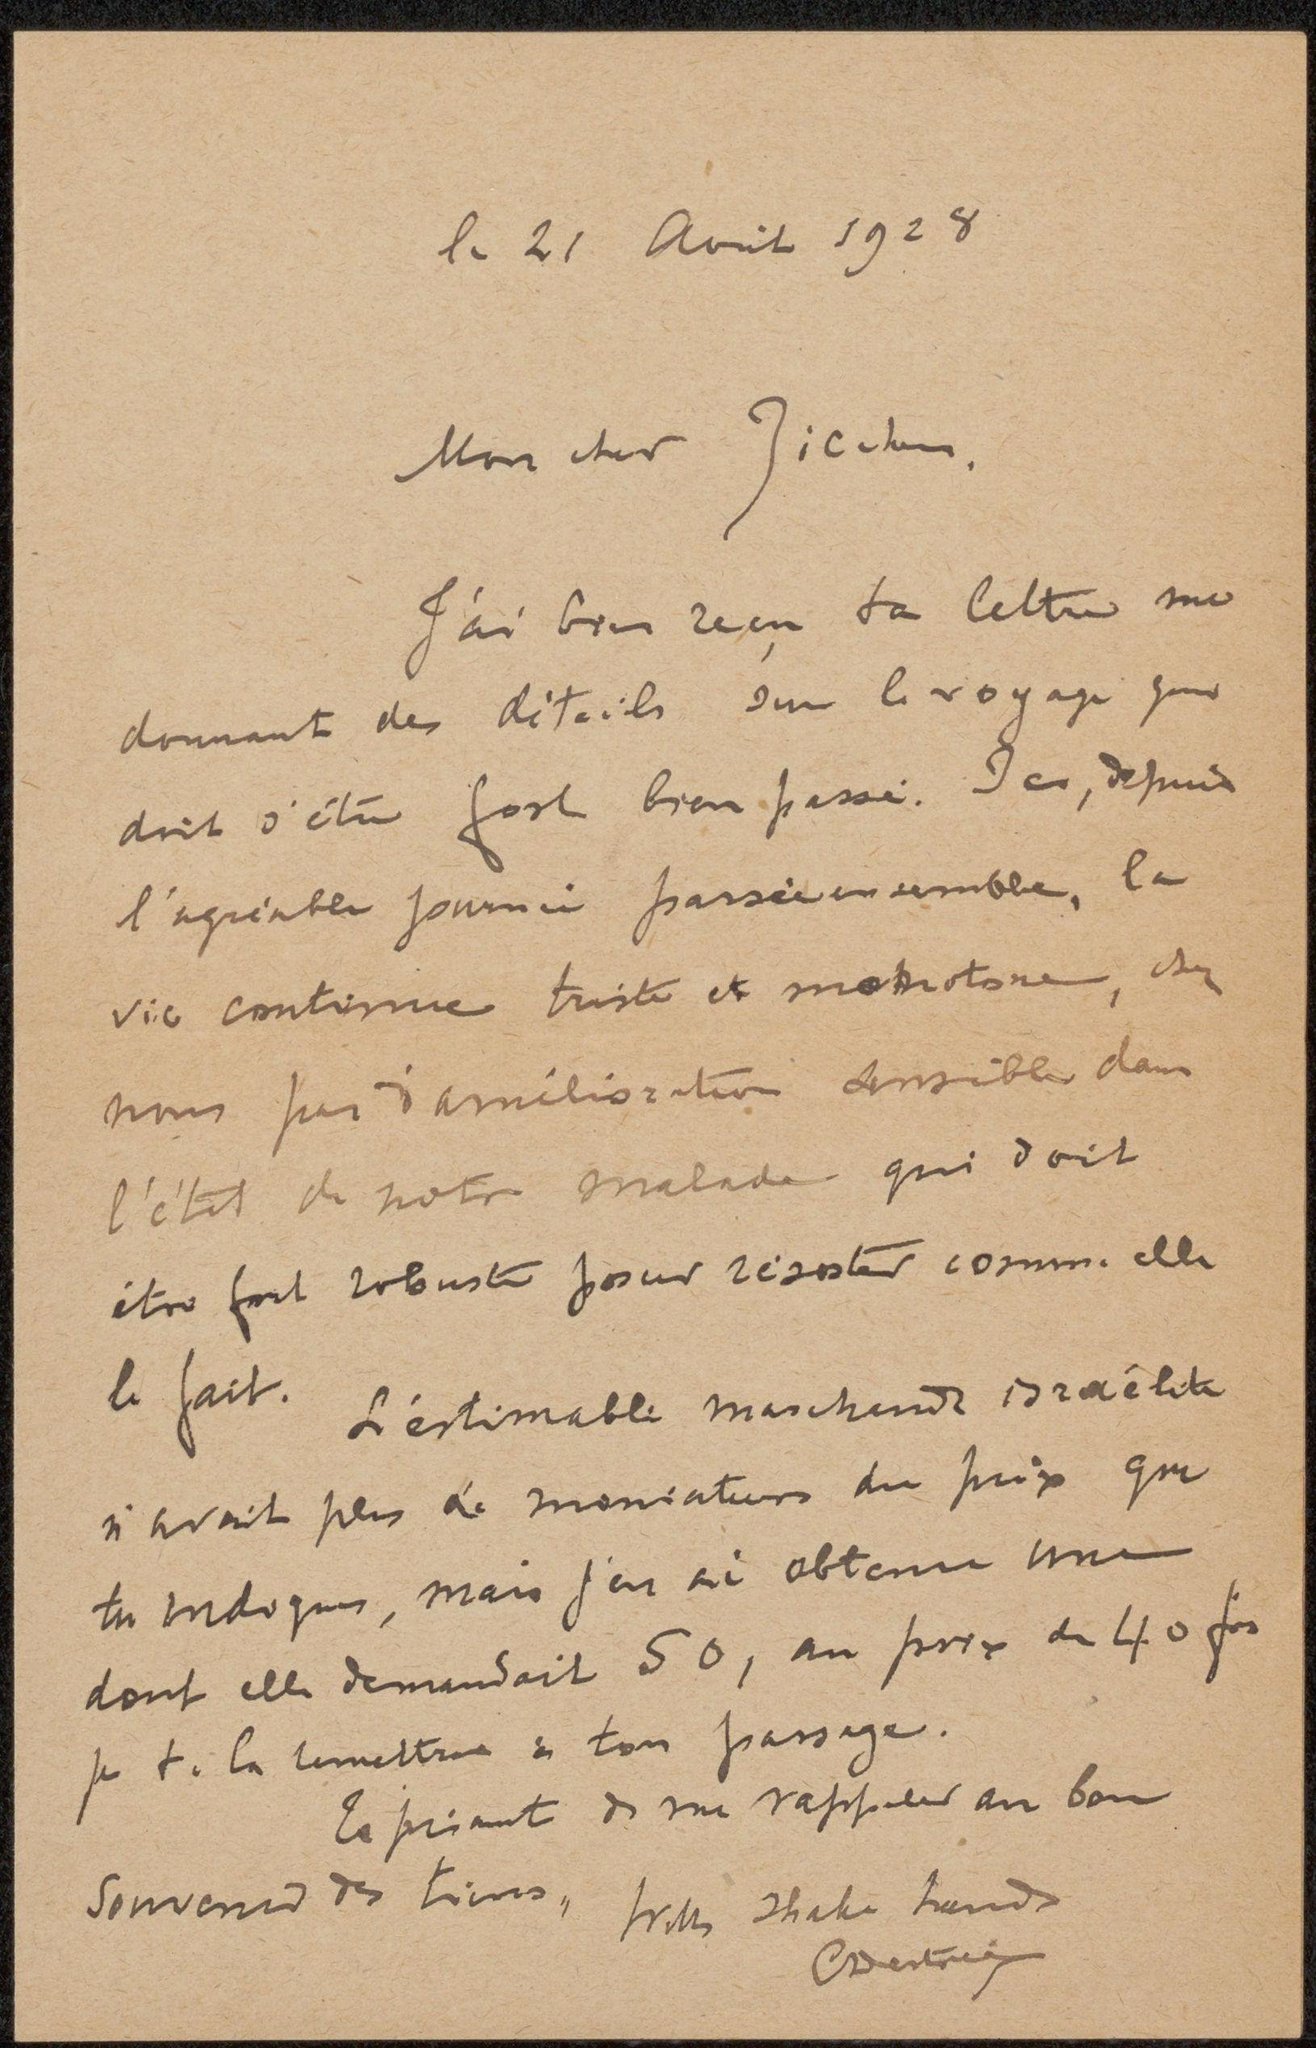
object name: letter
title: Brief aan Philip Zilcken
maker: charles destrée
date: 1928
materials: ink, paper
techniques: pen, writing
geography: paris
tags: the hague, painter, draughtsman, philip zilcken, diseases, money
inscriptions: collector's mark: ‘RPK’